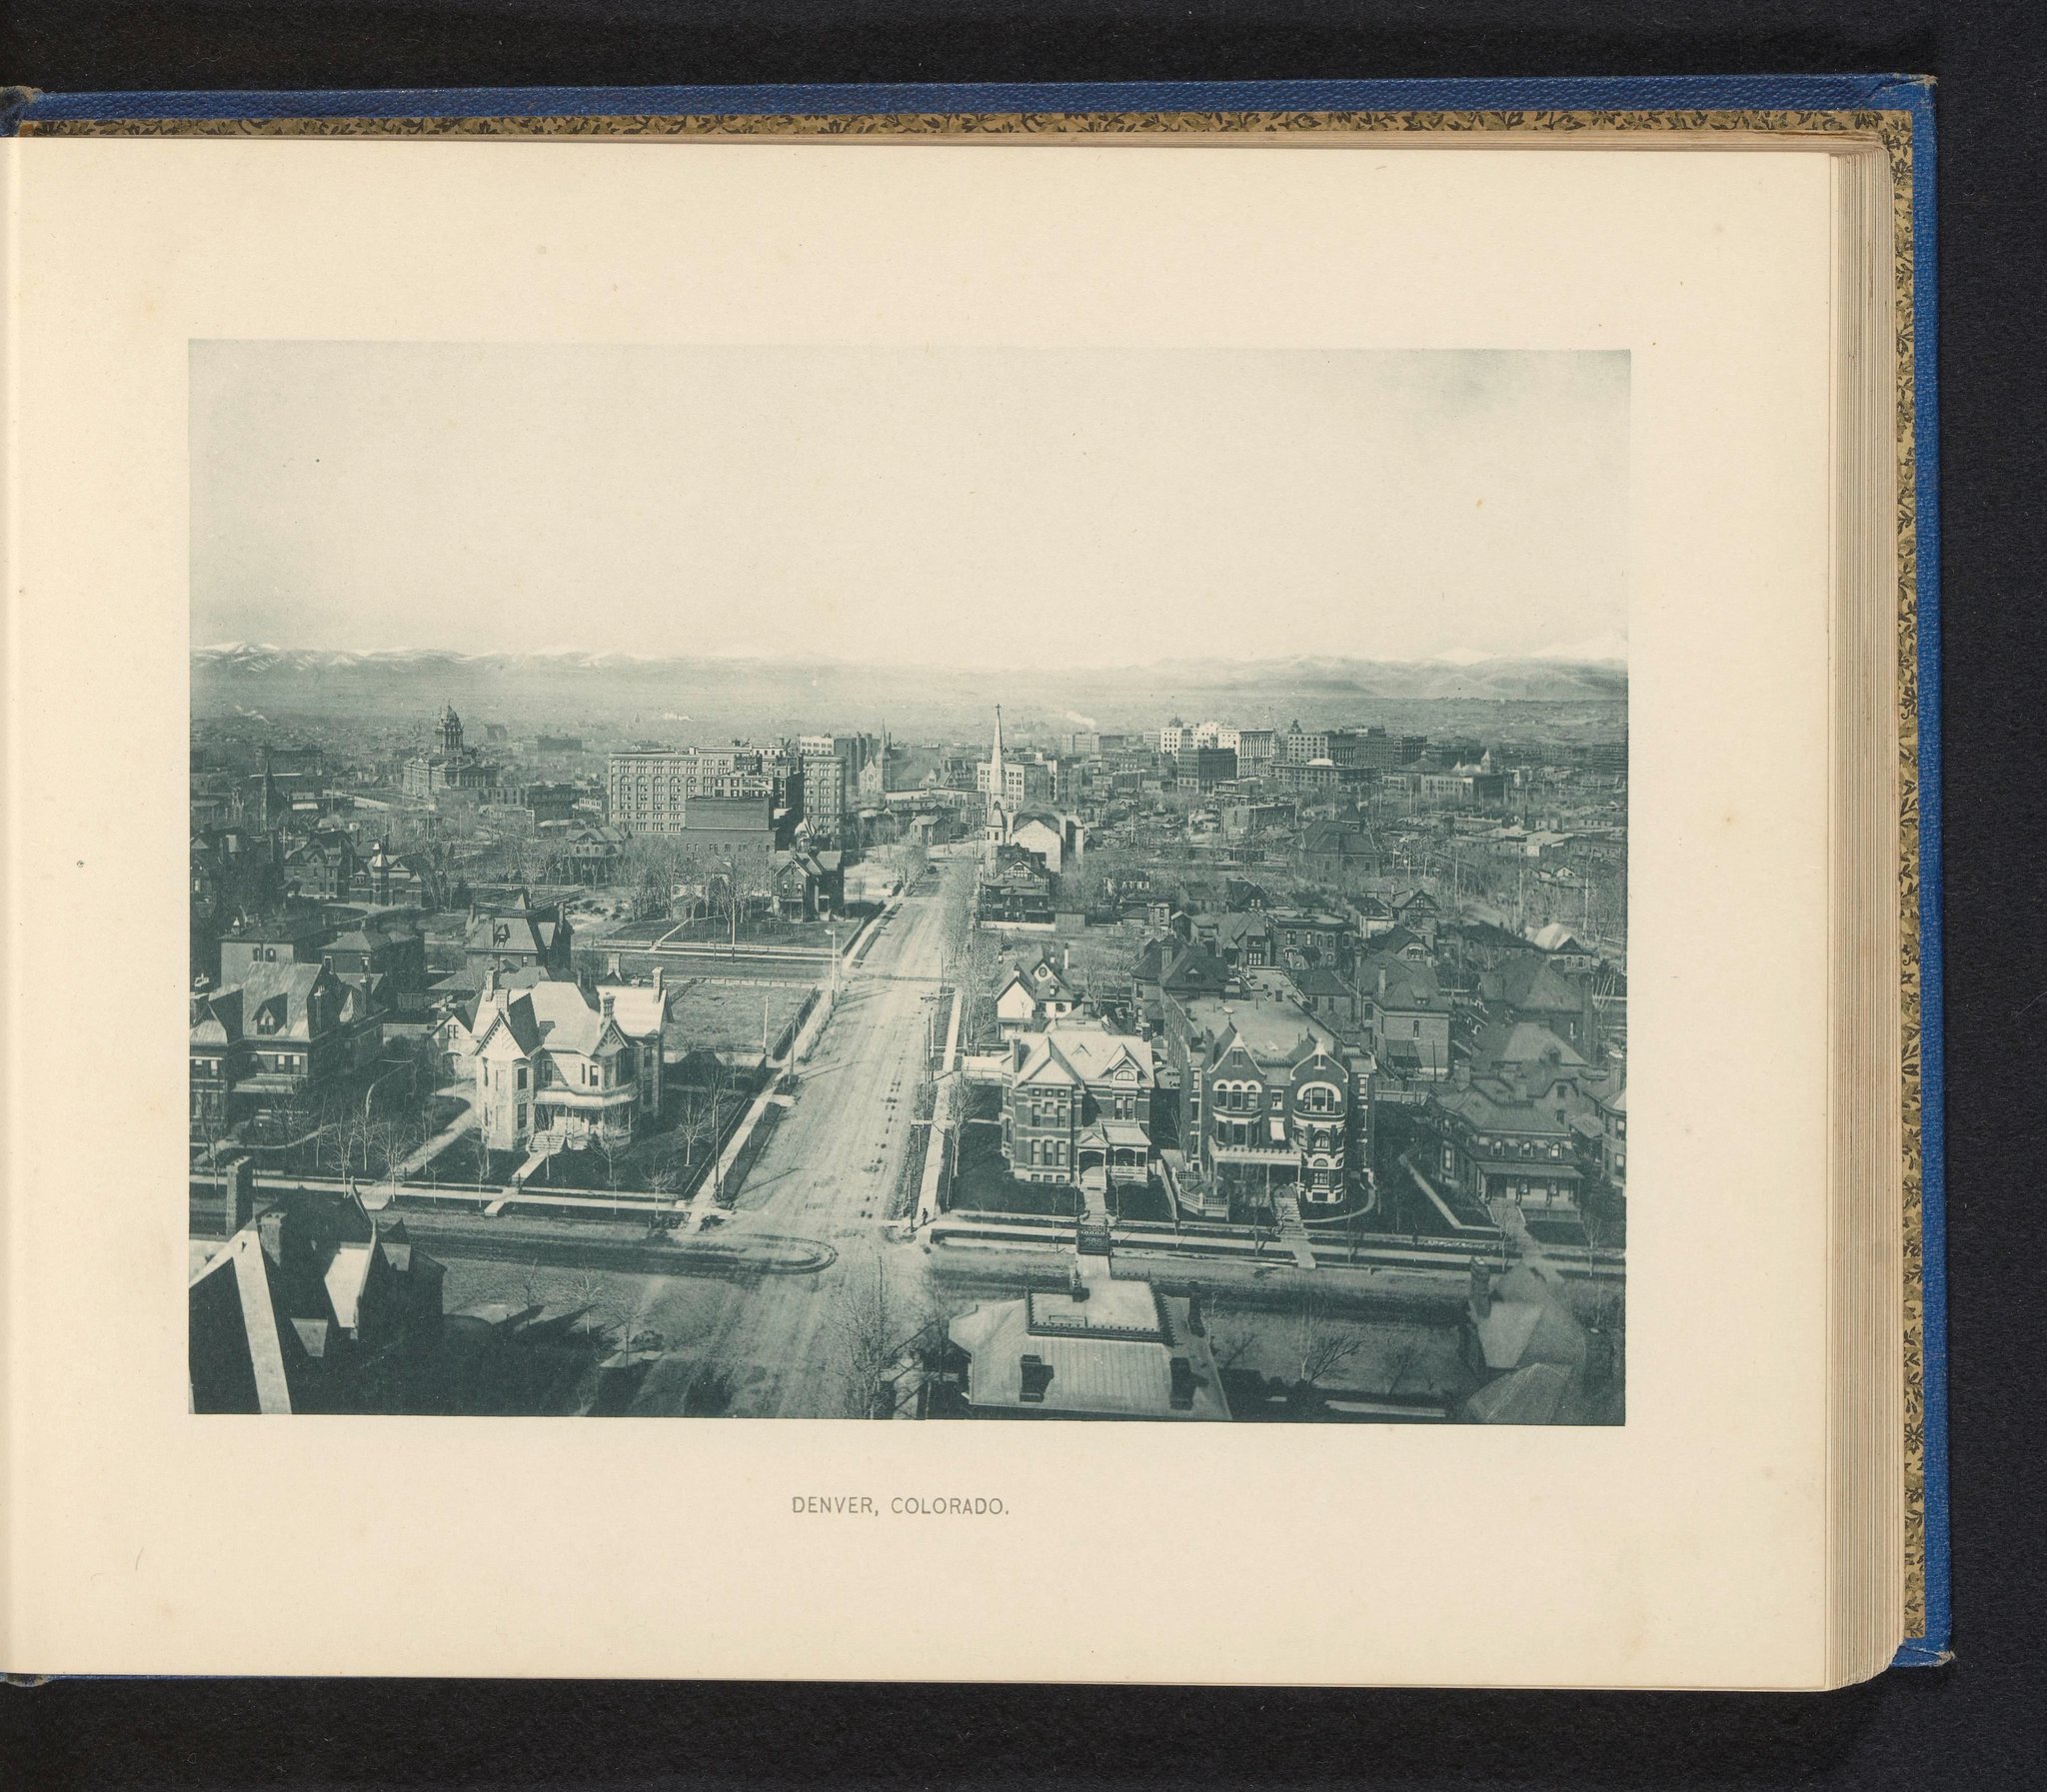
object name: photomechanical print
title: Denver, Colorado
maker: Anonymous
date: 1883-1893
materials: paper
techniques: photograph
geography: denver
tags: city-view, and landscape with man-made constructions